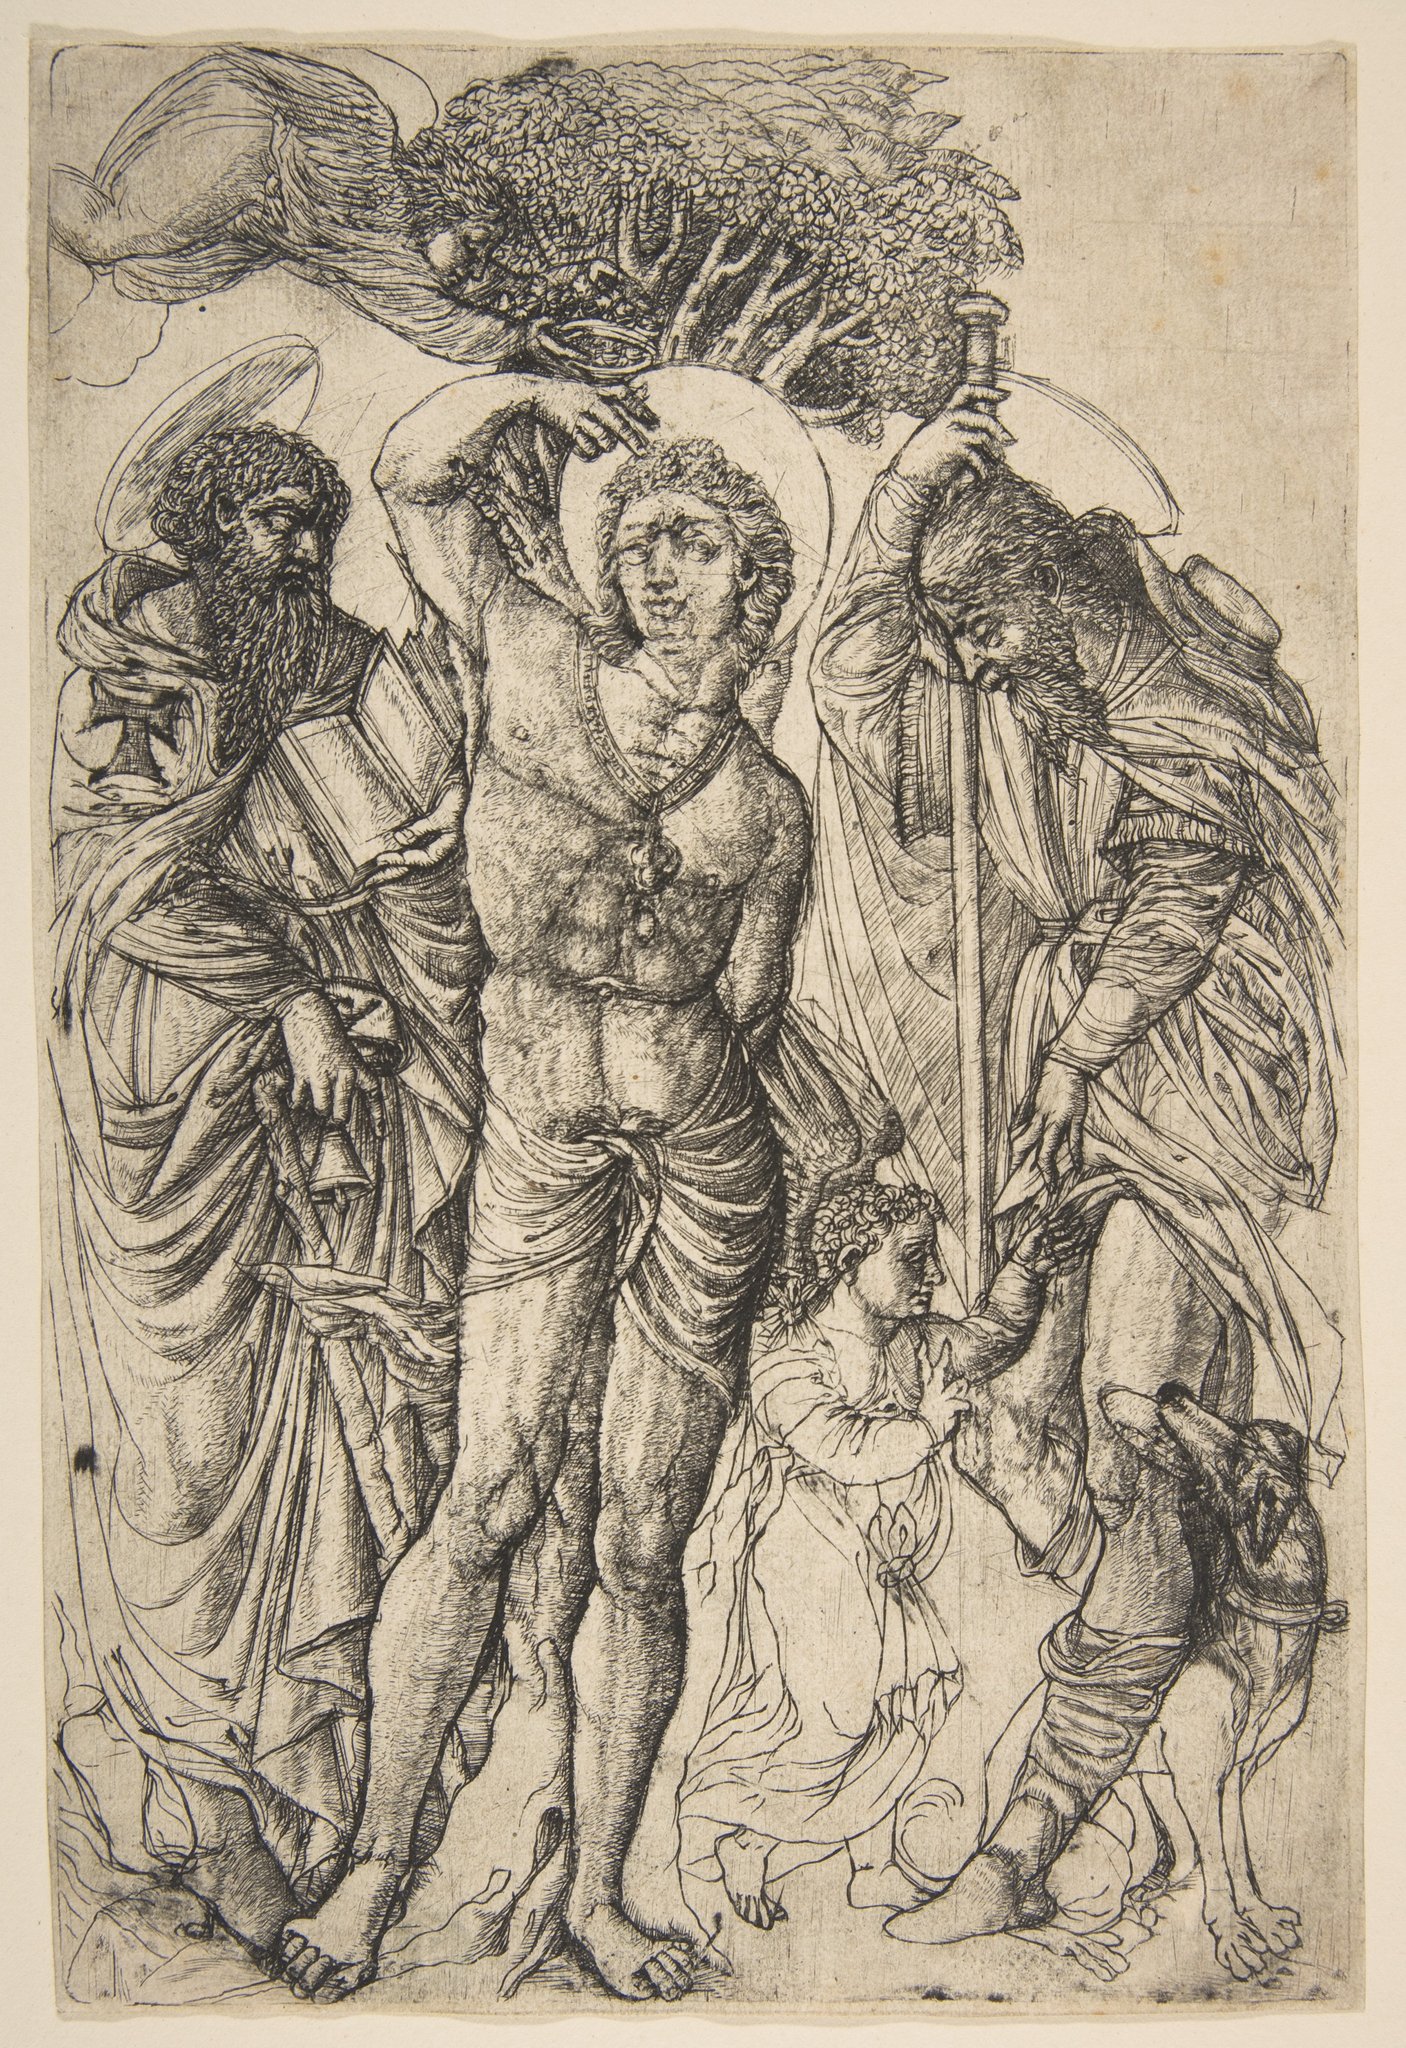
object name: print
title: Saints Sebastian, Anthony and Roch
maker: jean duvet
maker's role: artist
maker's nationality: french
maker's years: 1485-1561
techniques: engraving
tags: men,women,saints